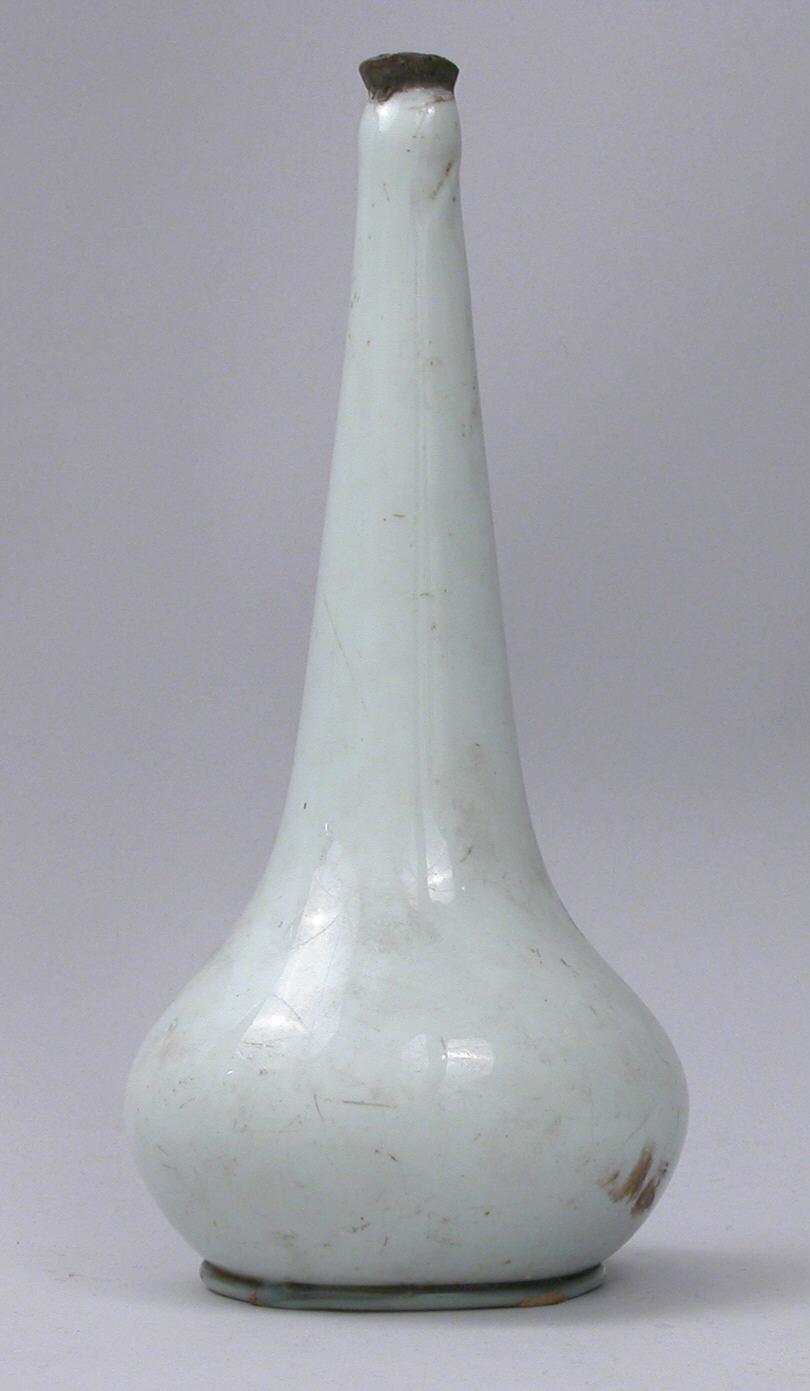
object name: bottle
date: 1701-1900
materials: glass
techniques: glassblowing, tooling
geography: iran